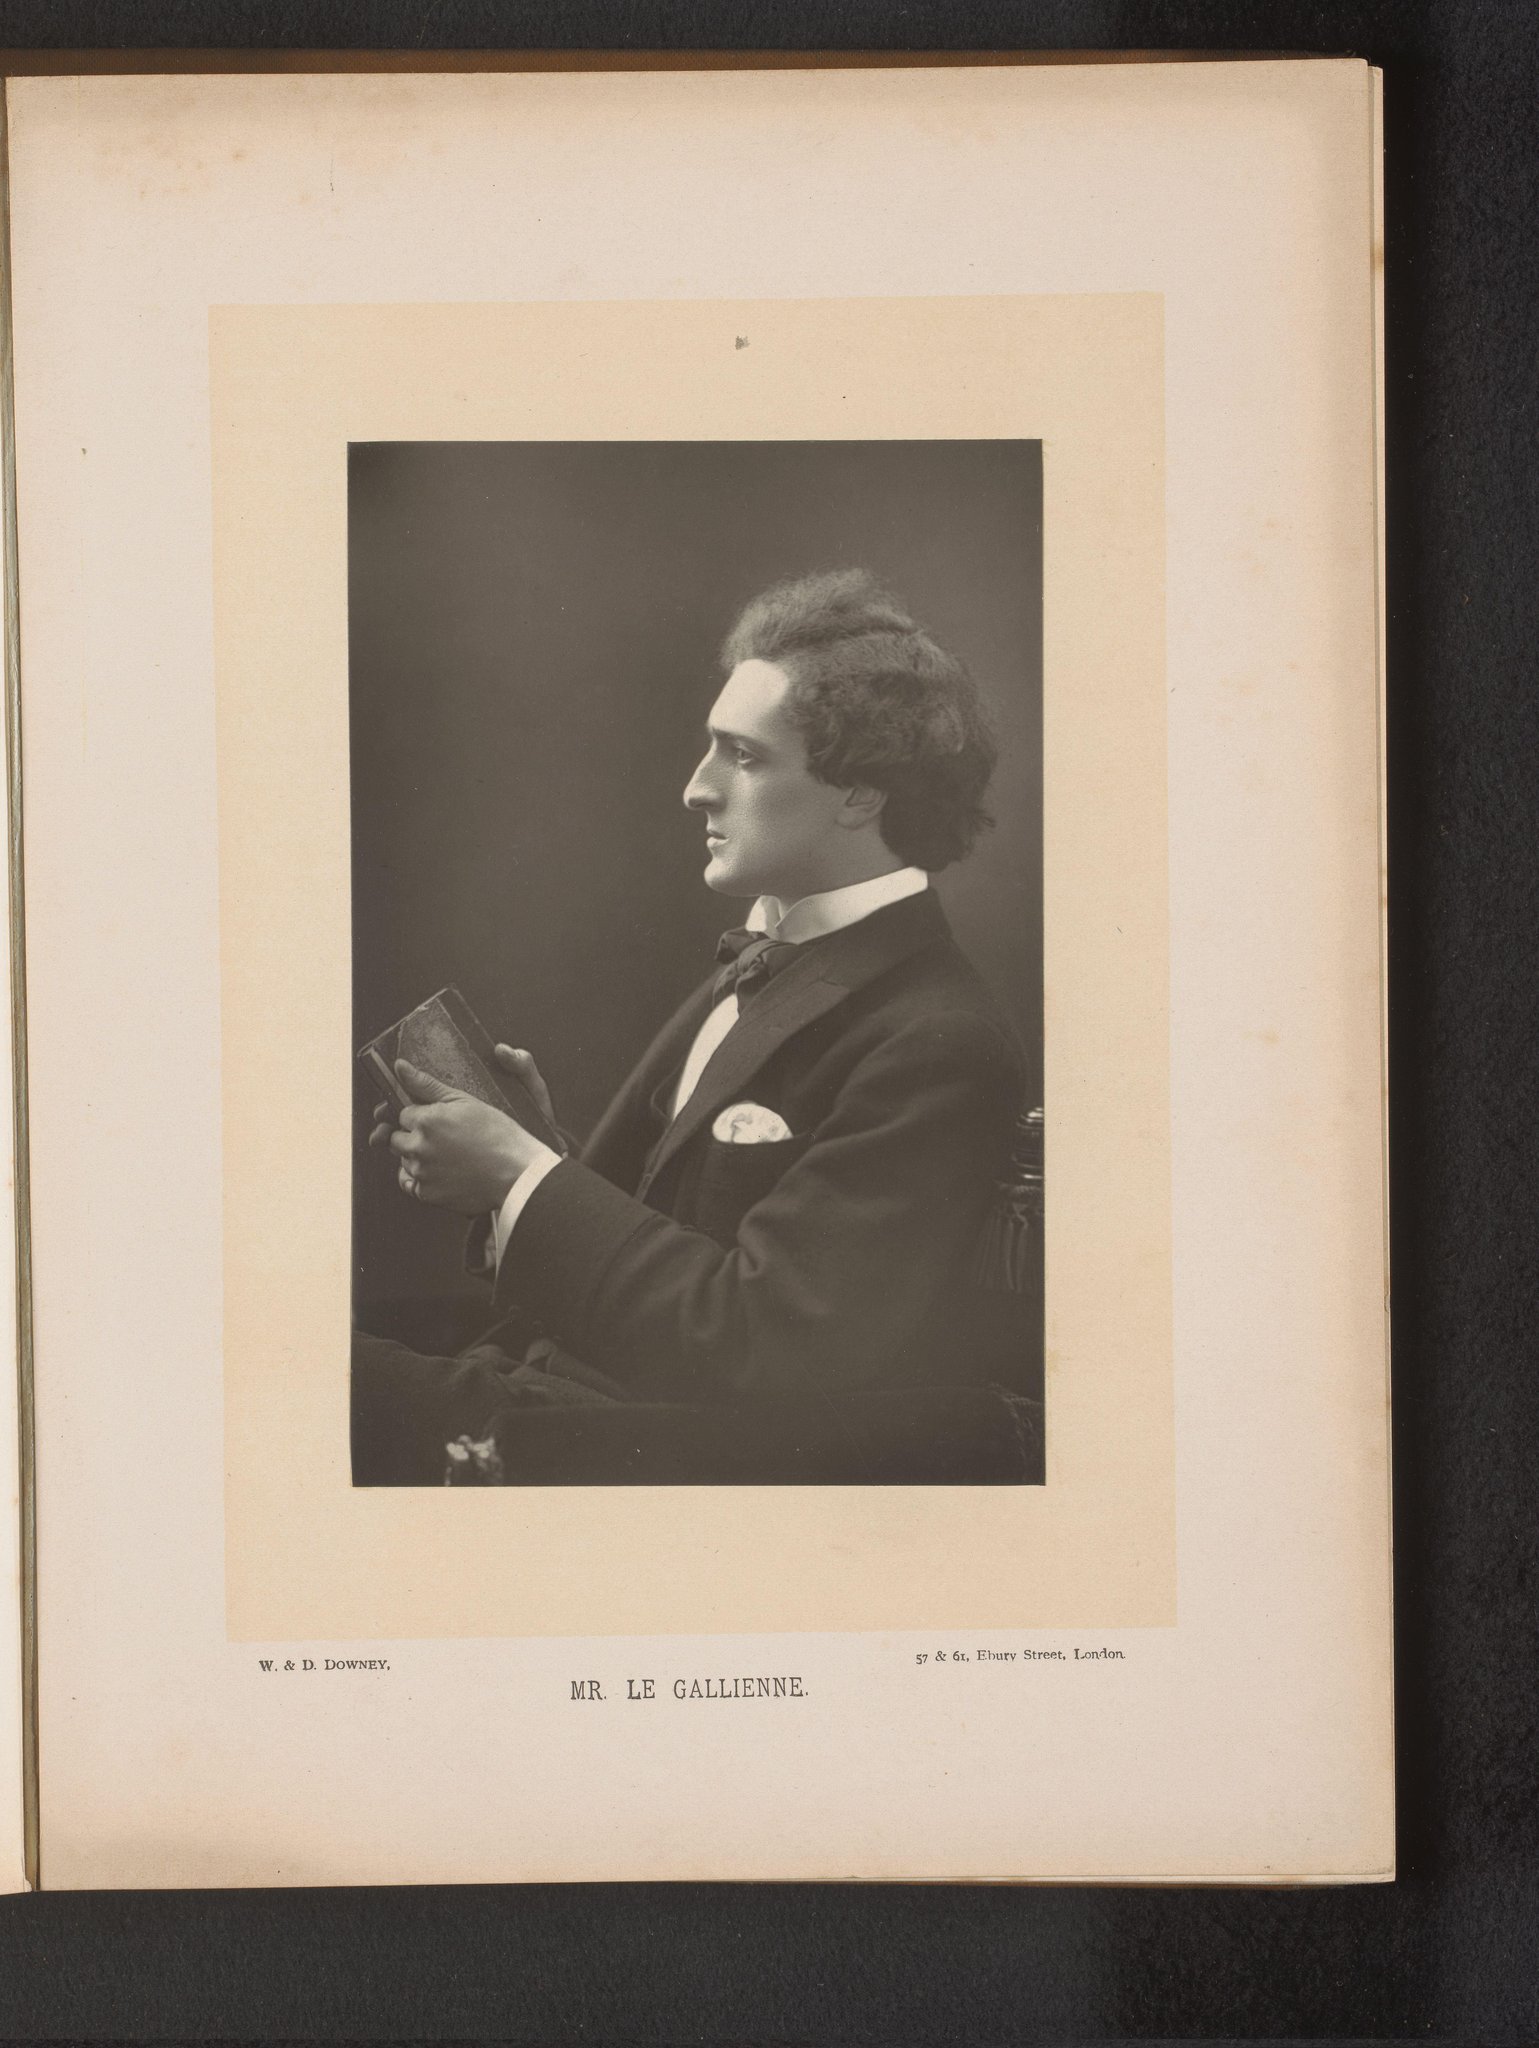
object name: photomechanical print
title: Mr. Le Gallienne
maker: Anonymous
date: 1884-1894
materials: paper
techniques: woodburytype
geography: london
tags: portrait of a writer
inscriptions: inscription: ‘57 & 61, Elbury Street, London.’